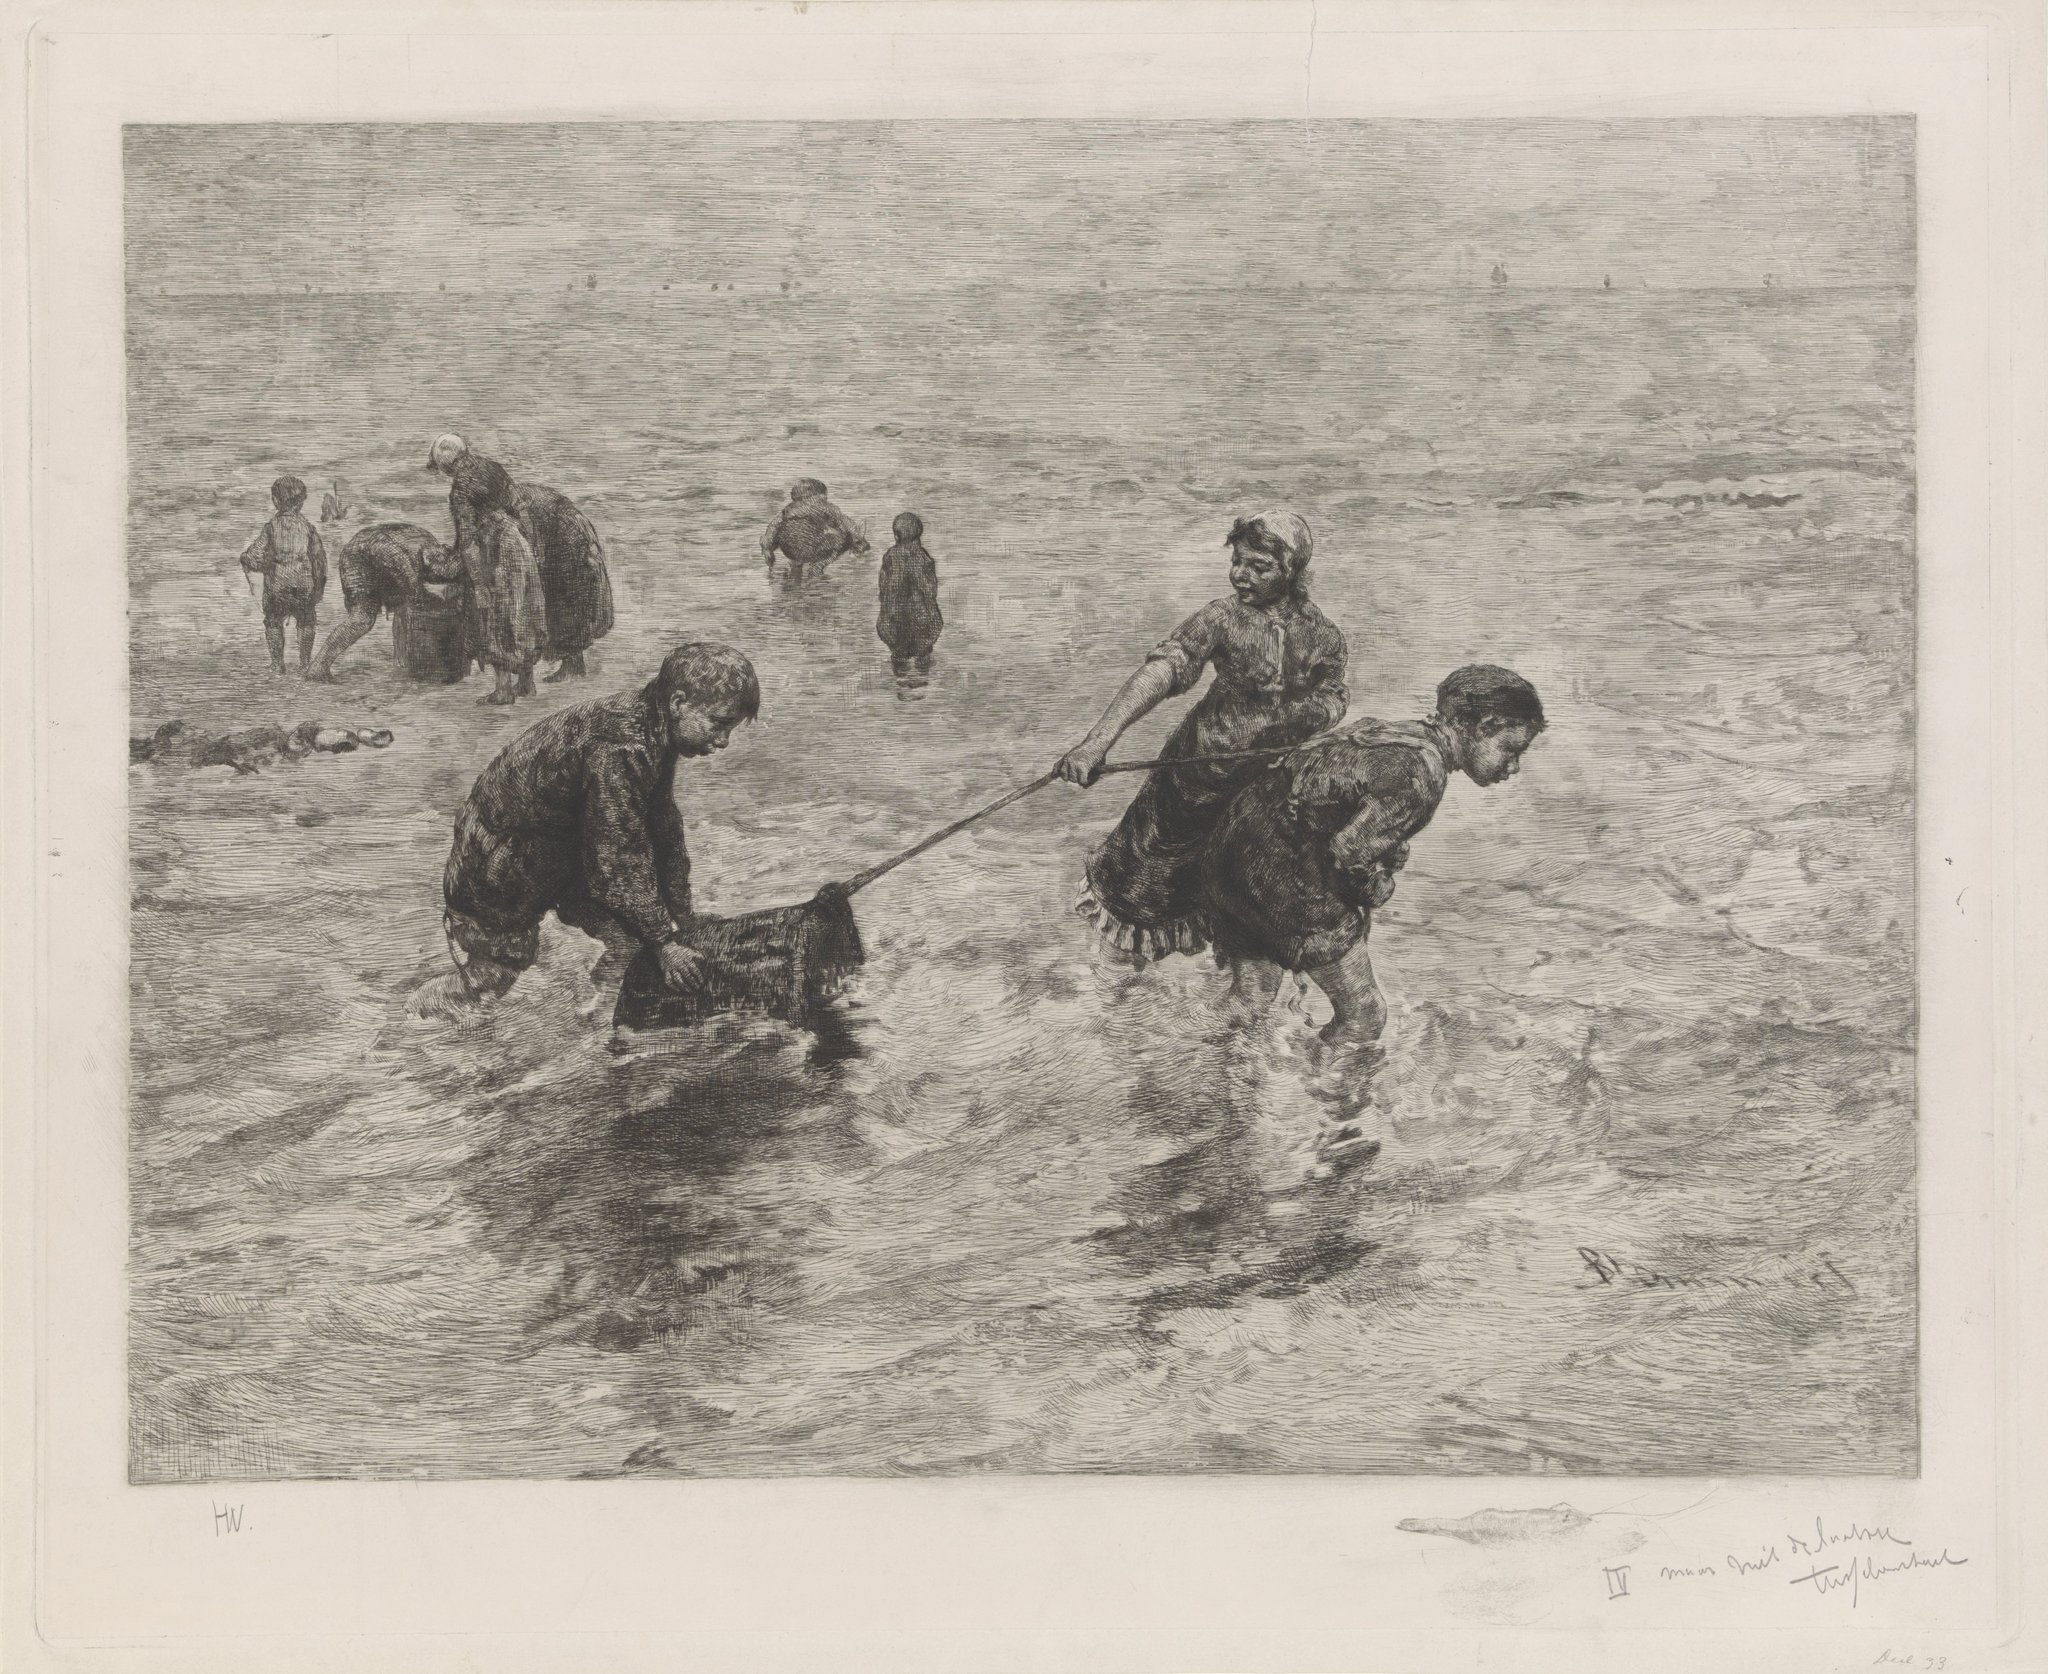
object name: print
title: Kinderen langs de zee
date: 1890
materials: paper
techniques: drypoint, etching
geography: amsterdam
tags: container made of plant material other than wood: basket, sea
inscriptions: signature: ‘HW’, collector's mark: Lugt 2228, inscription: ‘maar niet de laatste ?’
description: Een jongen trekt met een touw op zijn rug een mand door het water. De mand fungeert als een soort zeef om garnaaltjes te vangen. Hij wordt geholpen door een meisje dat aan het touw trekt, en een jongen die de mand duwt. In de marge een grote garnaal.